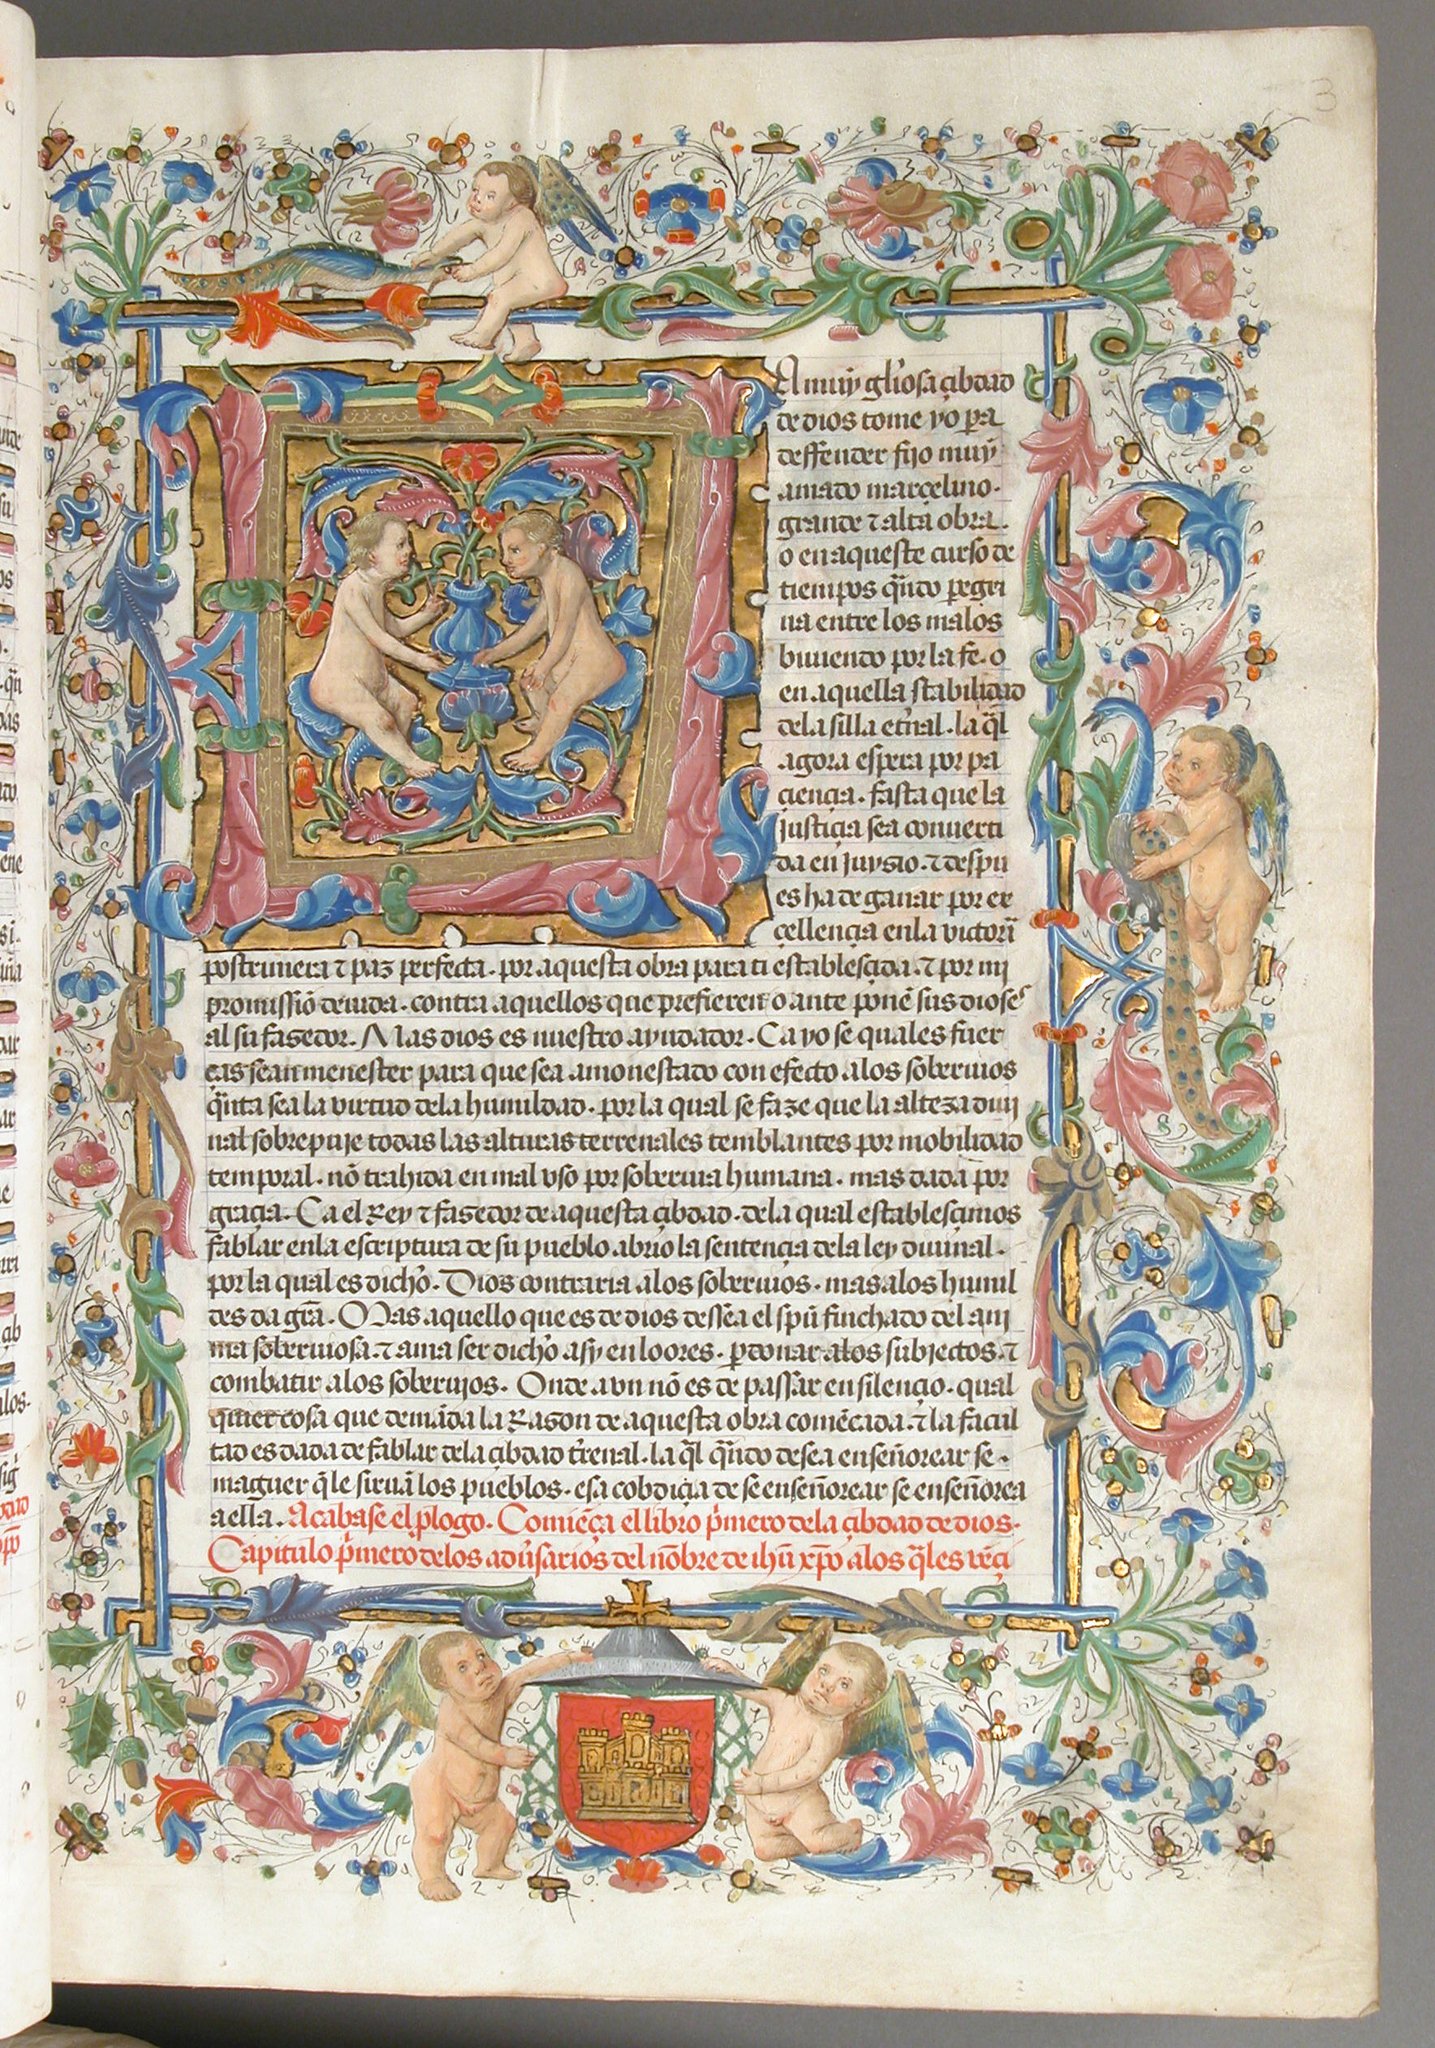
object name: manuscript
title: Spanish Translation of Saint Augustine's "City of God"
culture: spanish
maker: cano de aranda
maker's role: artist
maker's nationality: spanish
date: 1446-1482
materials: gold, leather, parchment, paint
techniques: bookbinding, tooling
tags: coat of arms